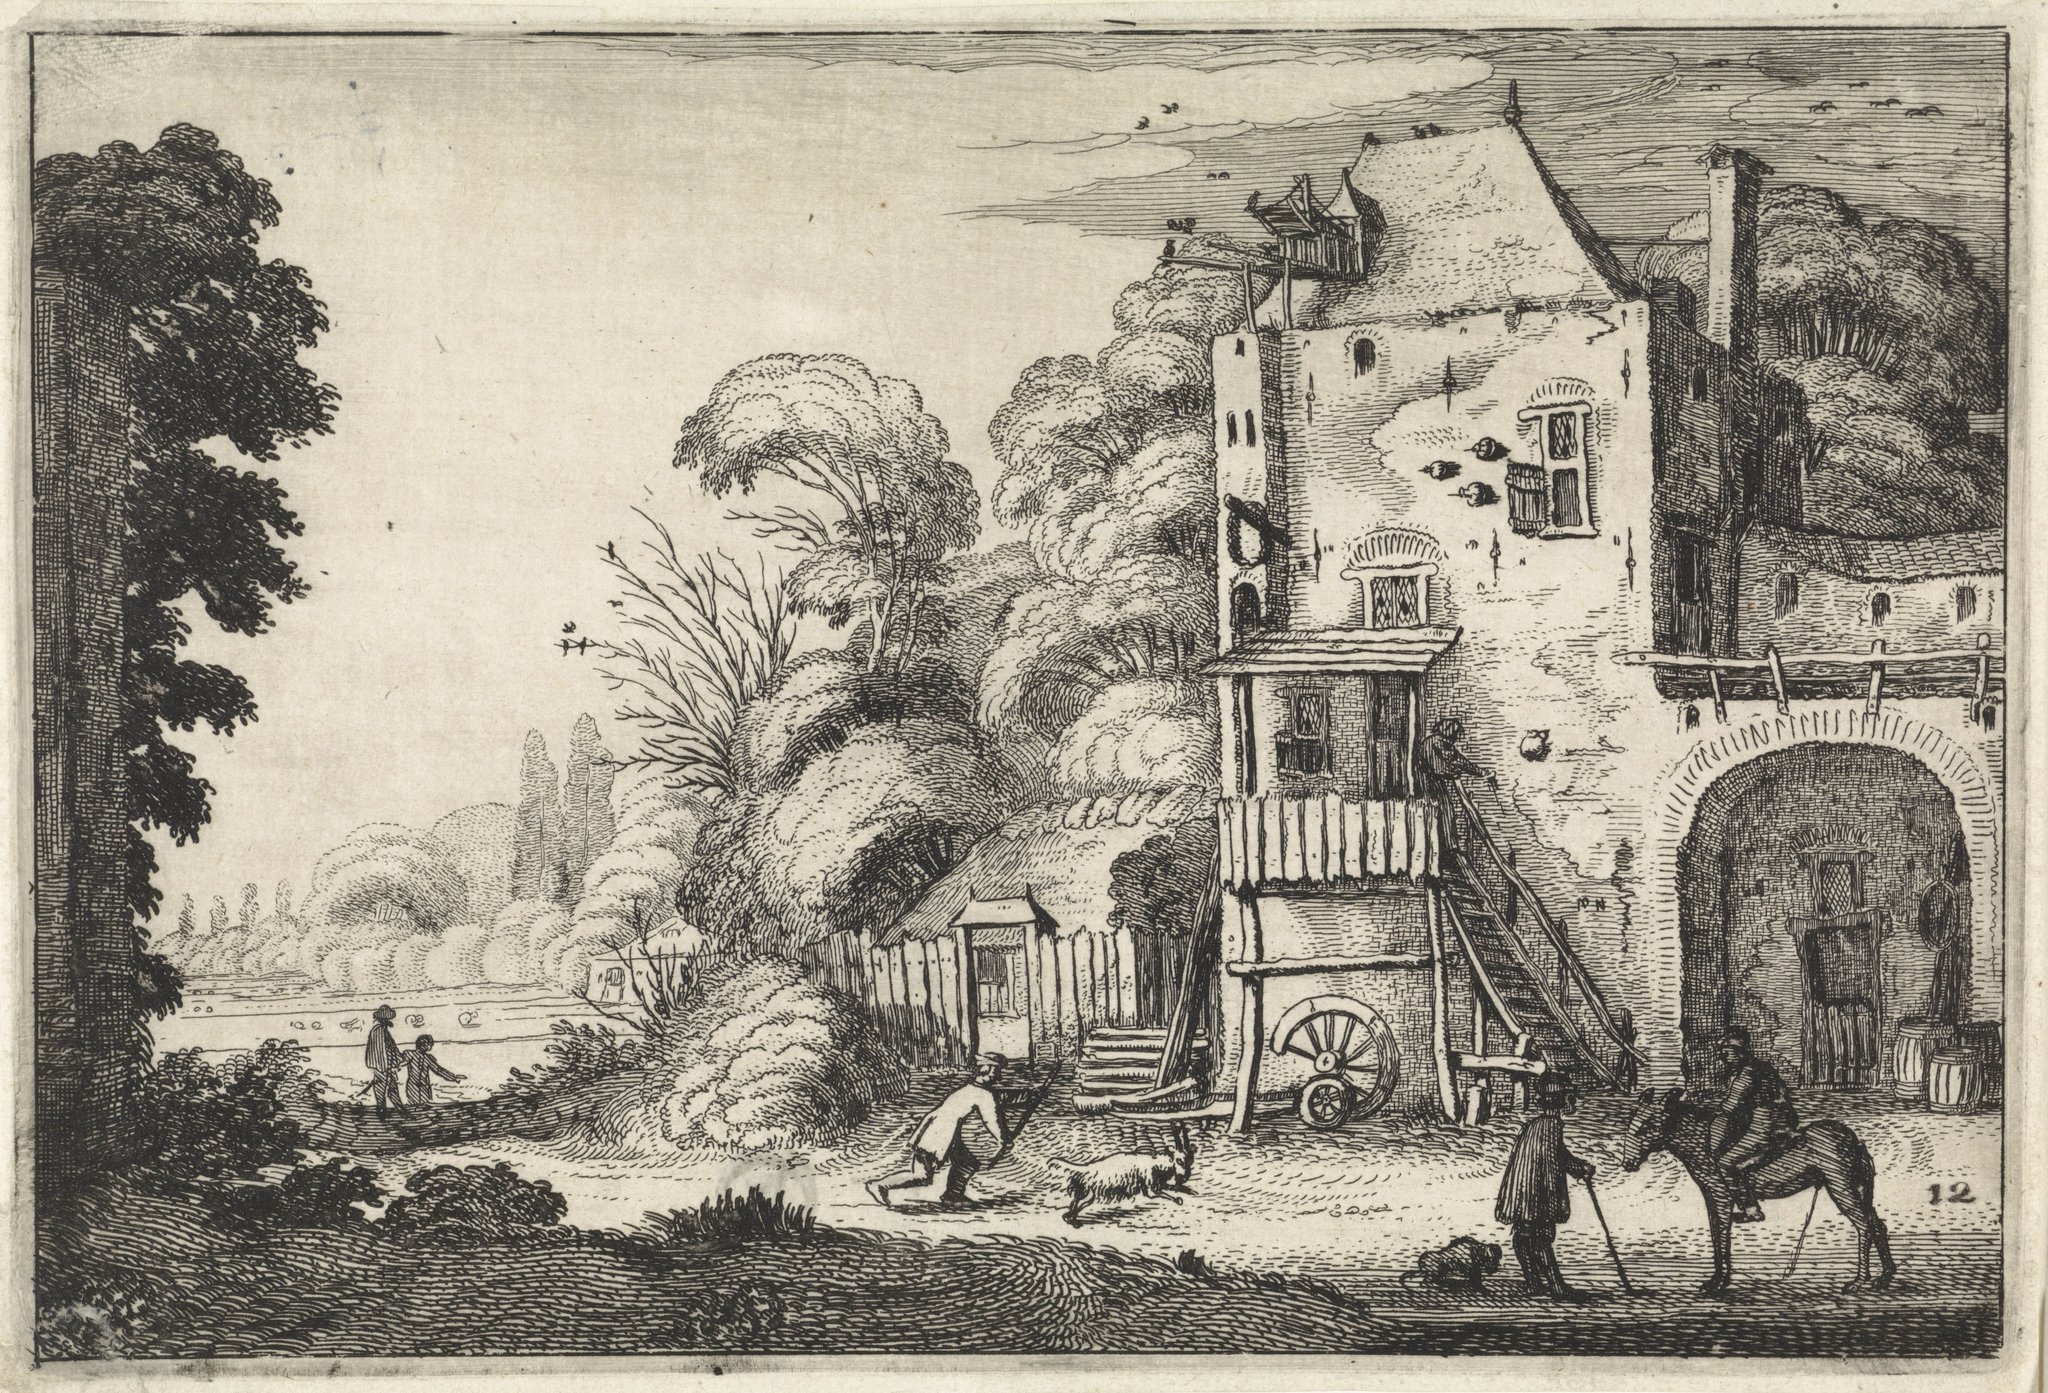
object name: print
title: Landschappen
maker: jan van de velde (ii)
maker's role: draughtsman, painter, print maker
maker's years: 1593-1641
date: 1616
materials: paper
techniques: etching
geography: northern netherlands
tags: riding a horse, ass, or mule; rider, horseman, farm or solitary house in landscape, hotel, hostelry, inn, tower (of house or building)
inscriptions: number: ‘12’, collector's mark: Lugt 964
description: Een herberg in een bomenrijk landschap. Op een pad een ruiter, een man met een hond en een man met een geit. Twaalfde prent van een serie van in totaal 52 prenten met landschappen, verdeeld over twee delen van elk 26 prenten.